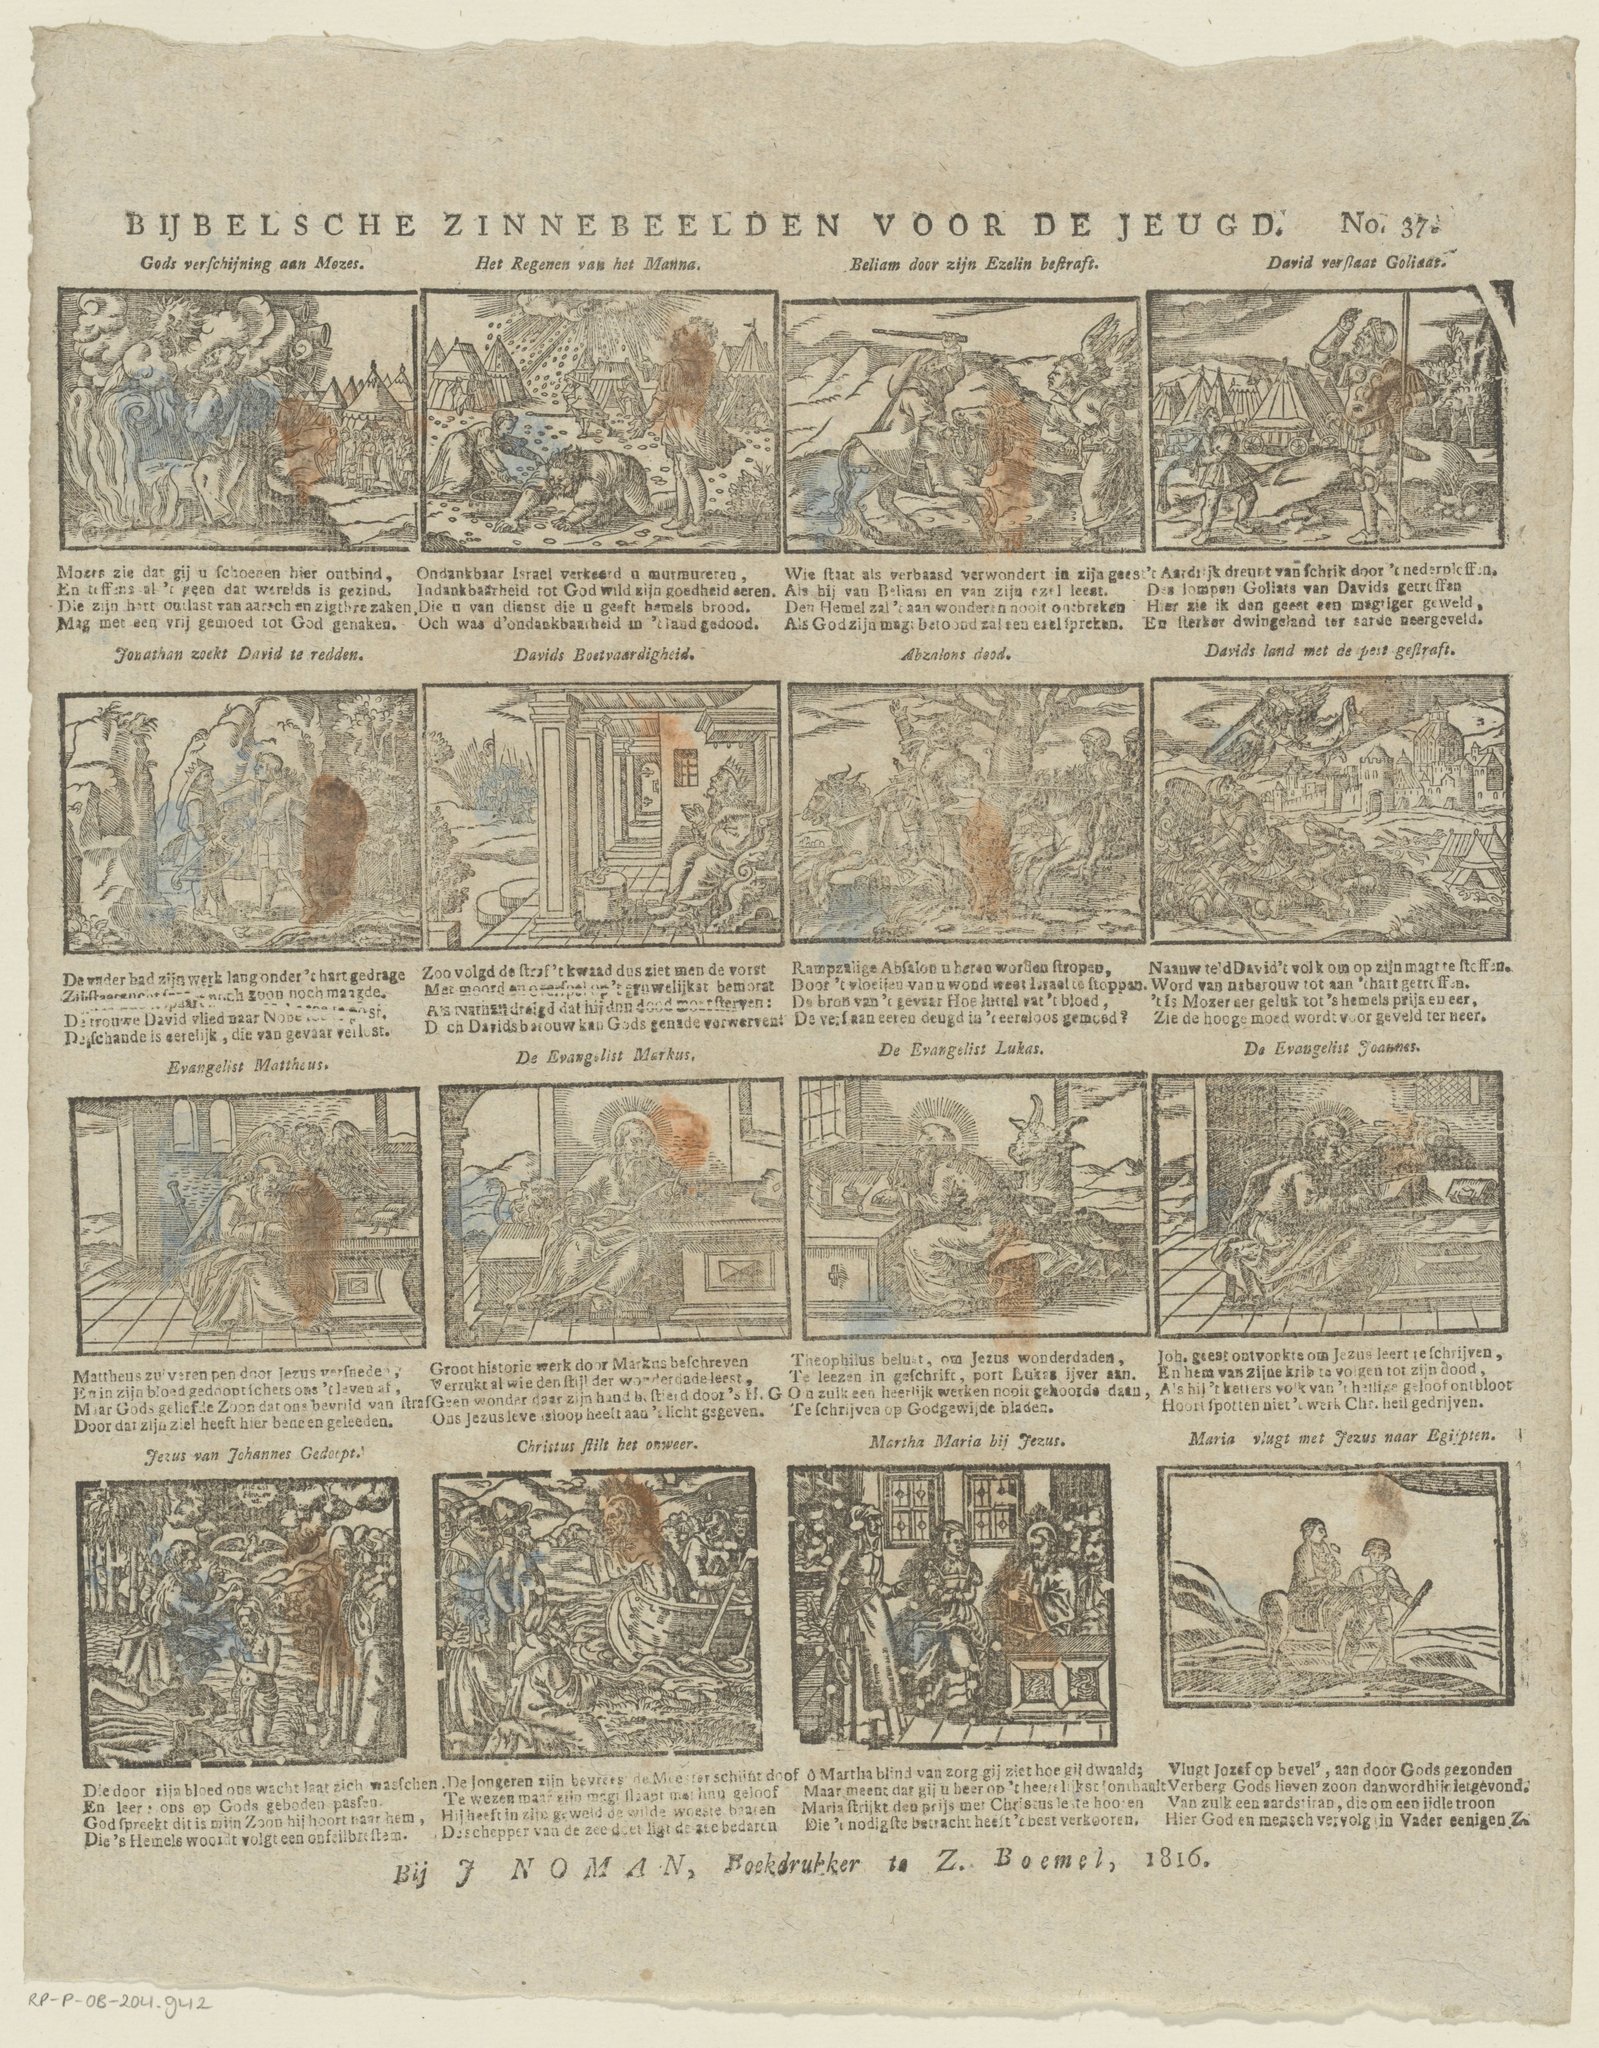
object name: print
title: Bijbelsche zinnebeelden voor de jeugd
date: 1806-1830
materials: paper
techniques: colour, letterpress printing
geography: zaltbommel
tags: evangelists, usually with books or scrolls (not in biblical context), the four evangelists ~ the four main prophets, new testament, old testament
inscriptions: collector's mark: Lugt 2760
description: Blad met 16 voorstellingen van verhalen uit het Oude en het Nieuwe Testament en van de vier evangelisten. Onder elke afbeelding een vierregelig vers, boven elke afbeelding een titel. Genummerd rechtsboven: No. 37.